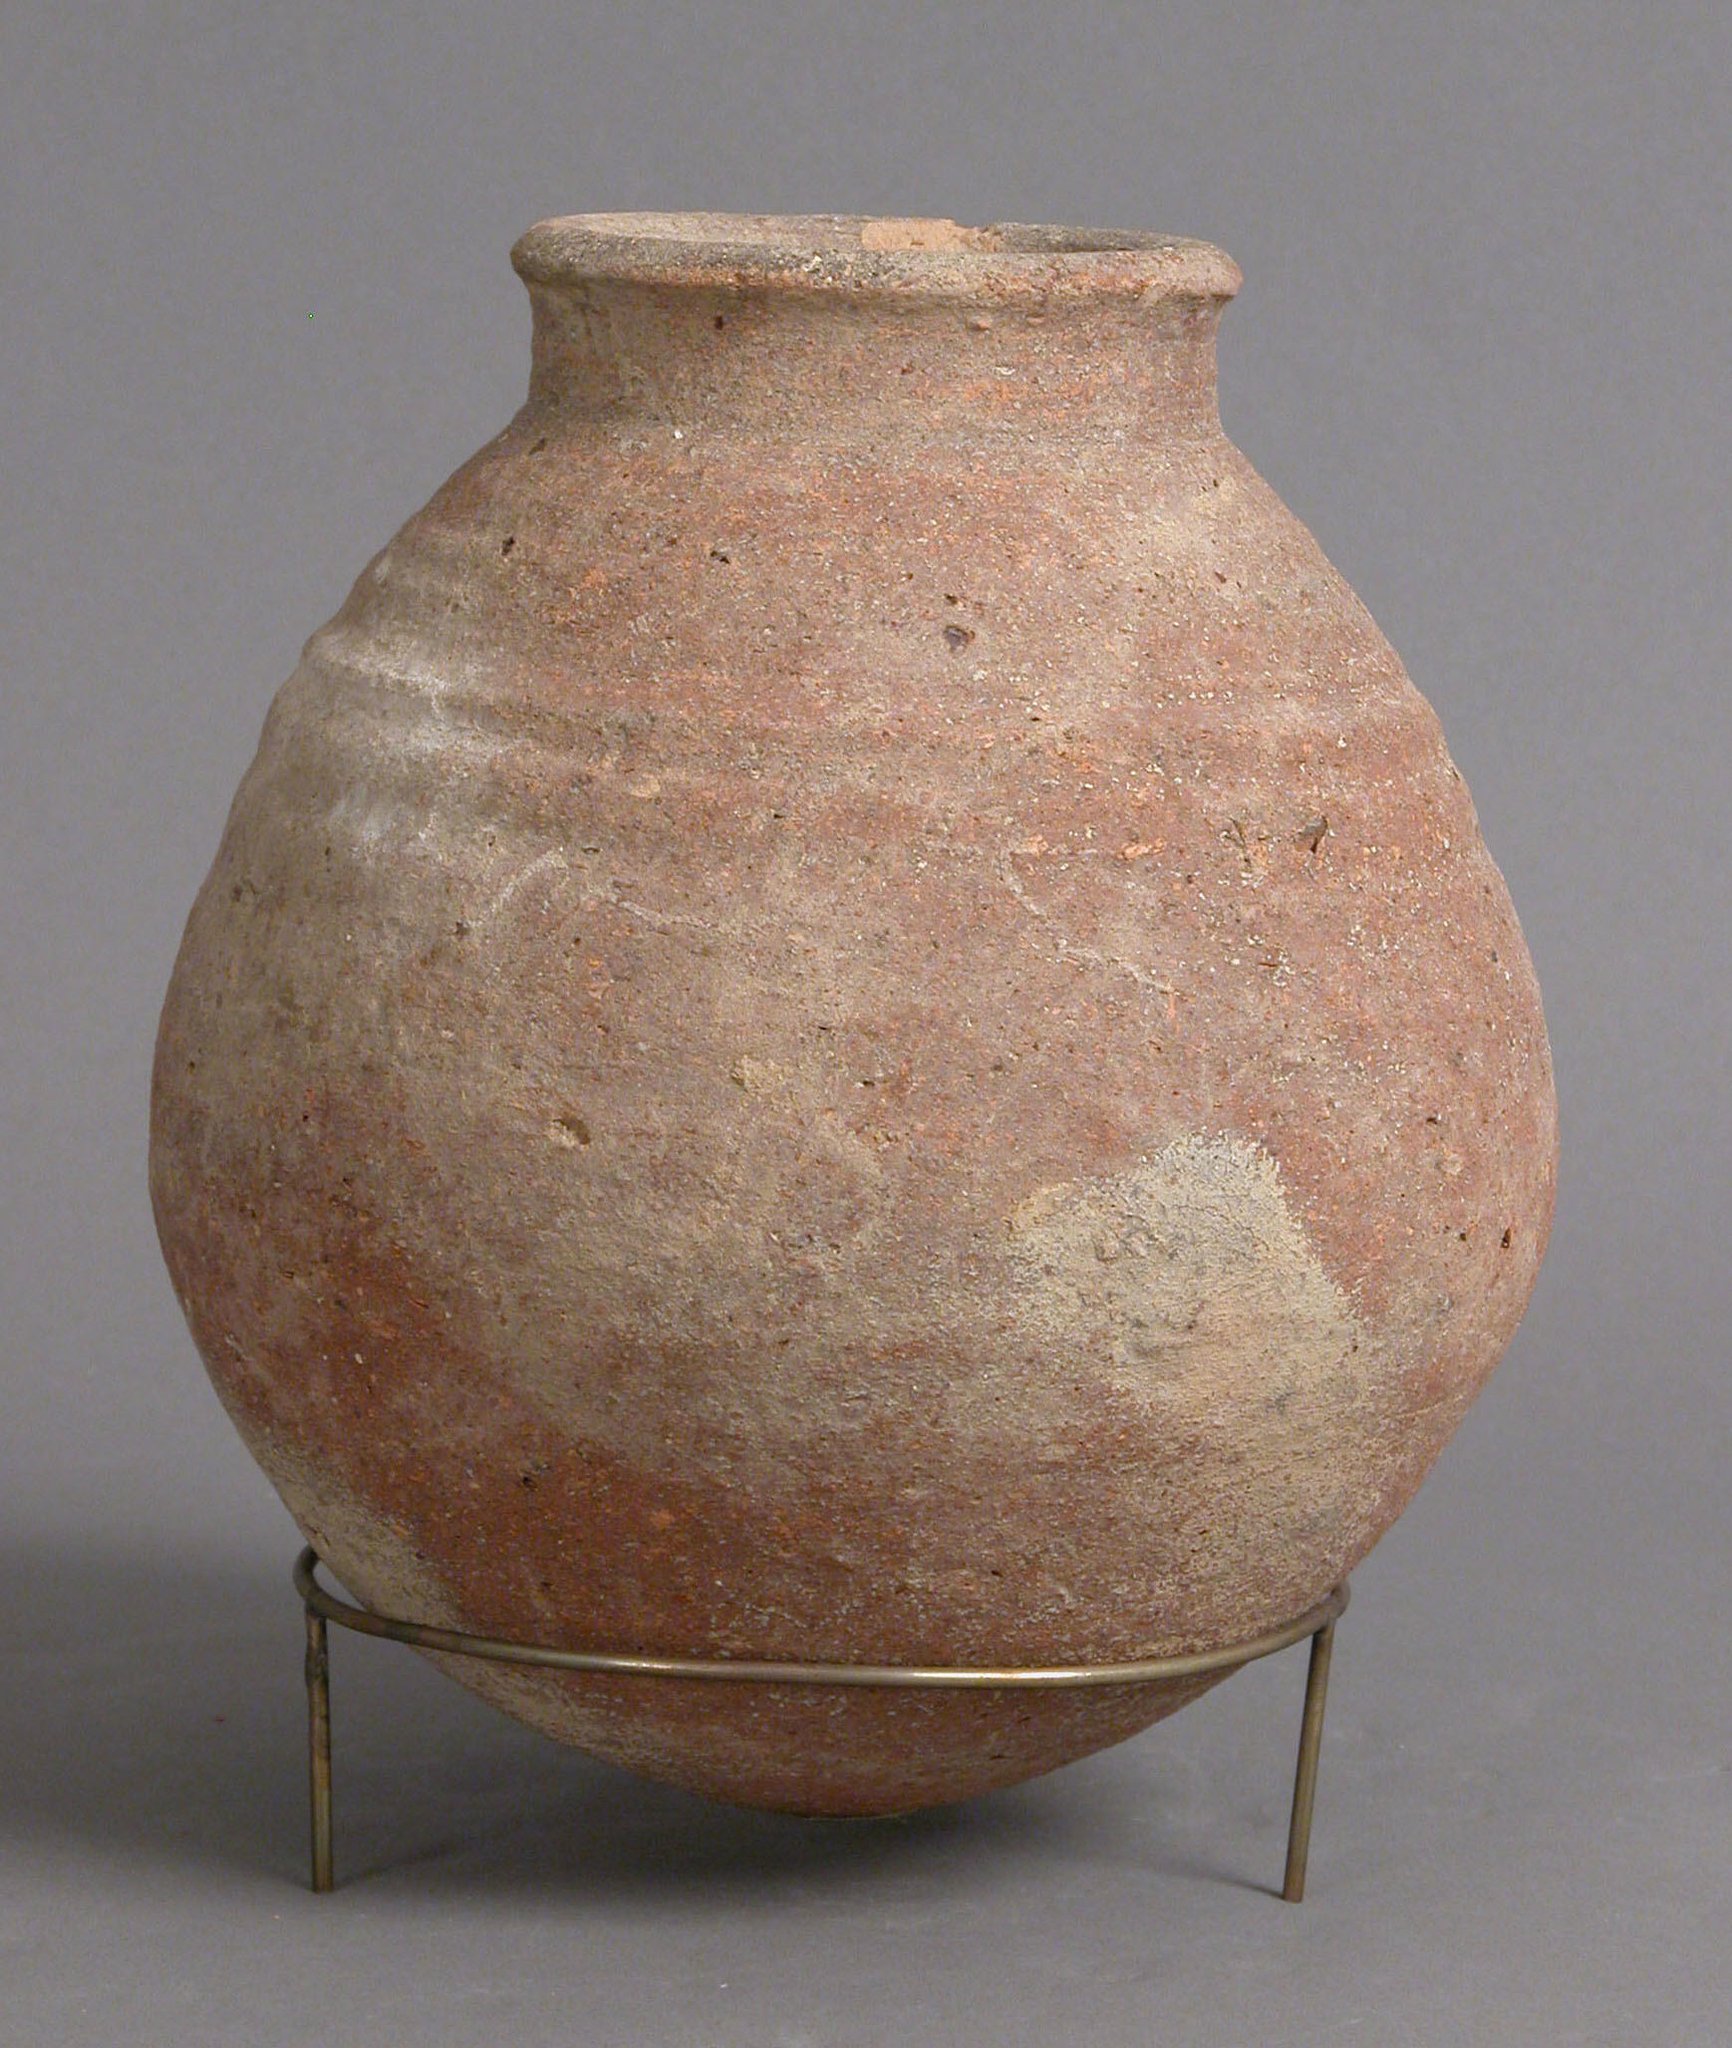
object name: vase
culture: coptic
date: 301-700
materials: earthenware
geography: egypt